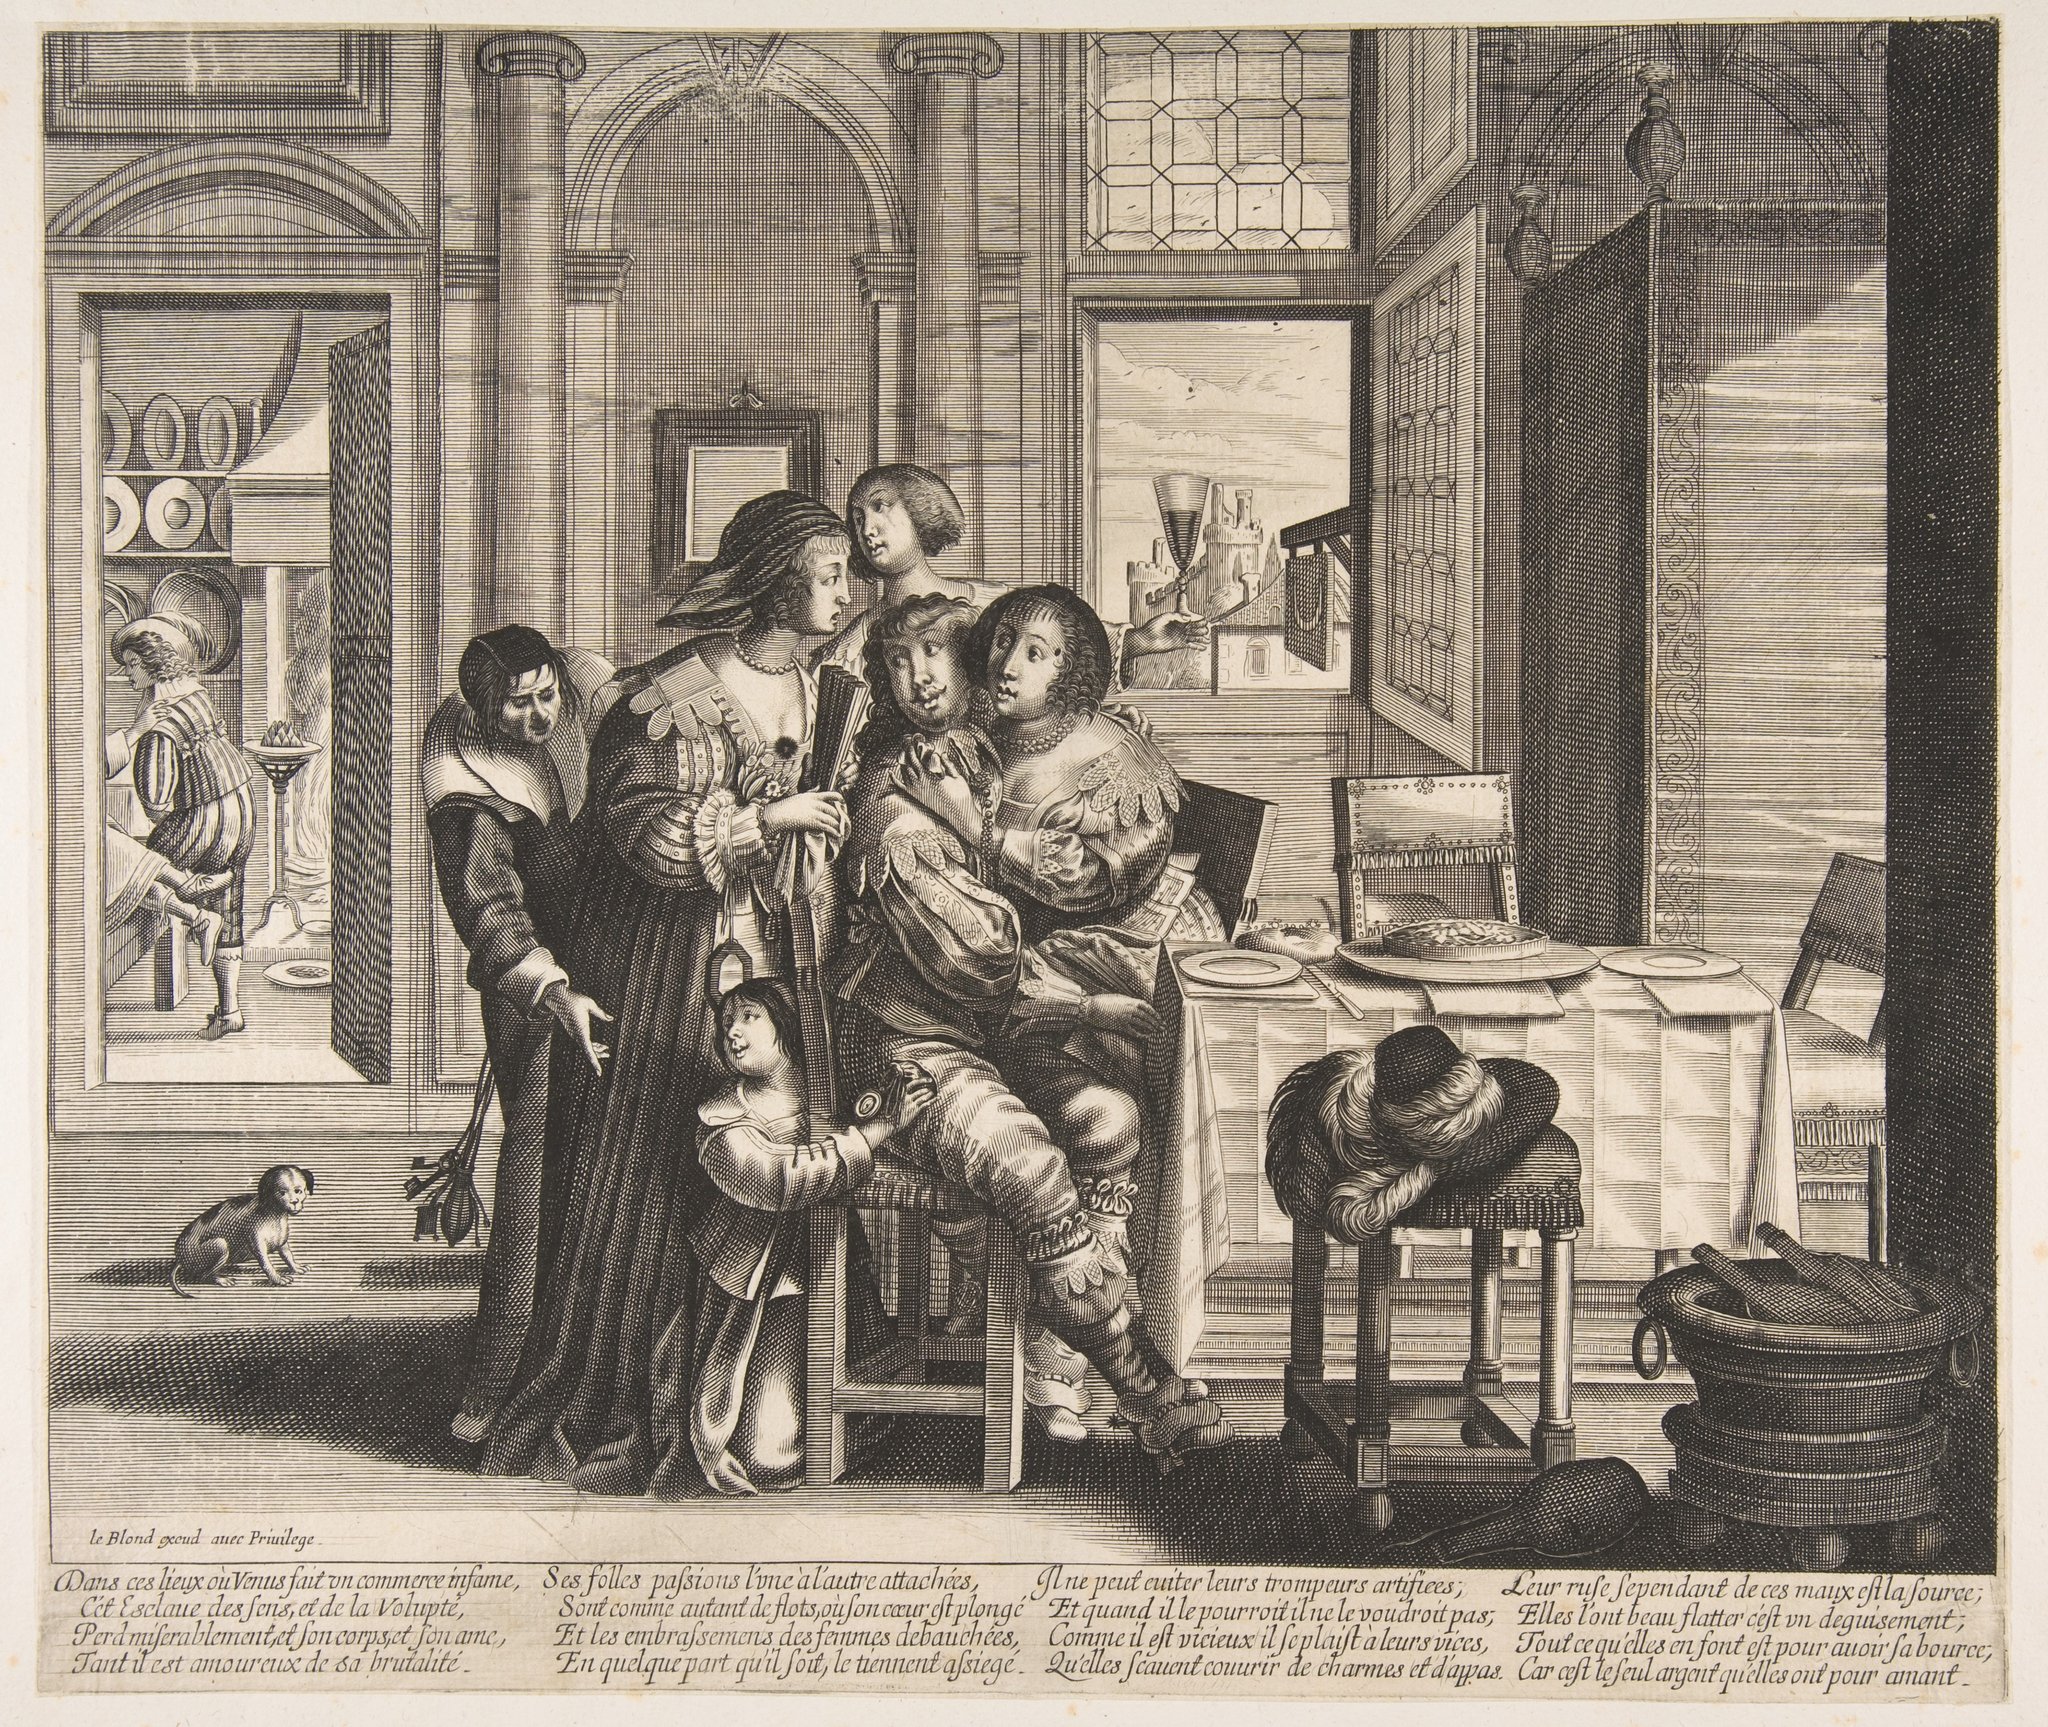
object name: print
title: The Prodigal Son in a House of Ill Repute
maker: Anonymous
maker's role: artist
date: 1636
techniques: engraving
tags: interiors,men,women